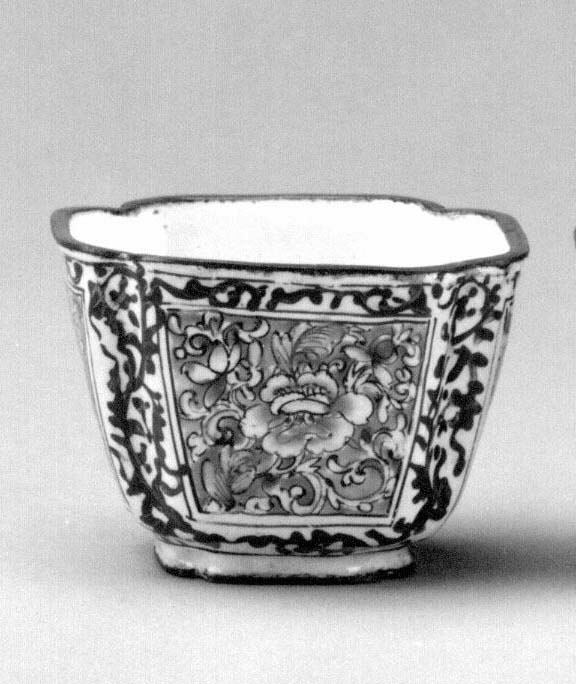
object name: cup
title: Square Cup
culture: chinese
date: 1801-1900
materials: enamel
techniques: painting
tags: flowers